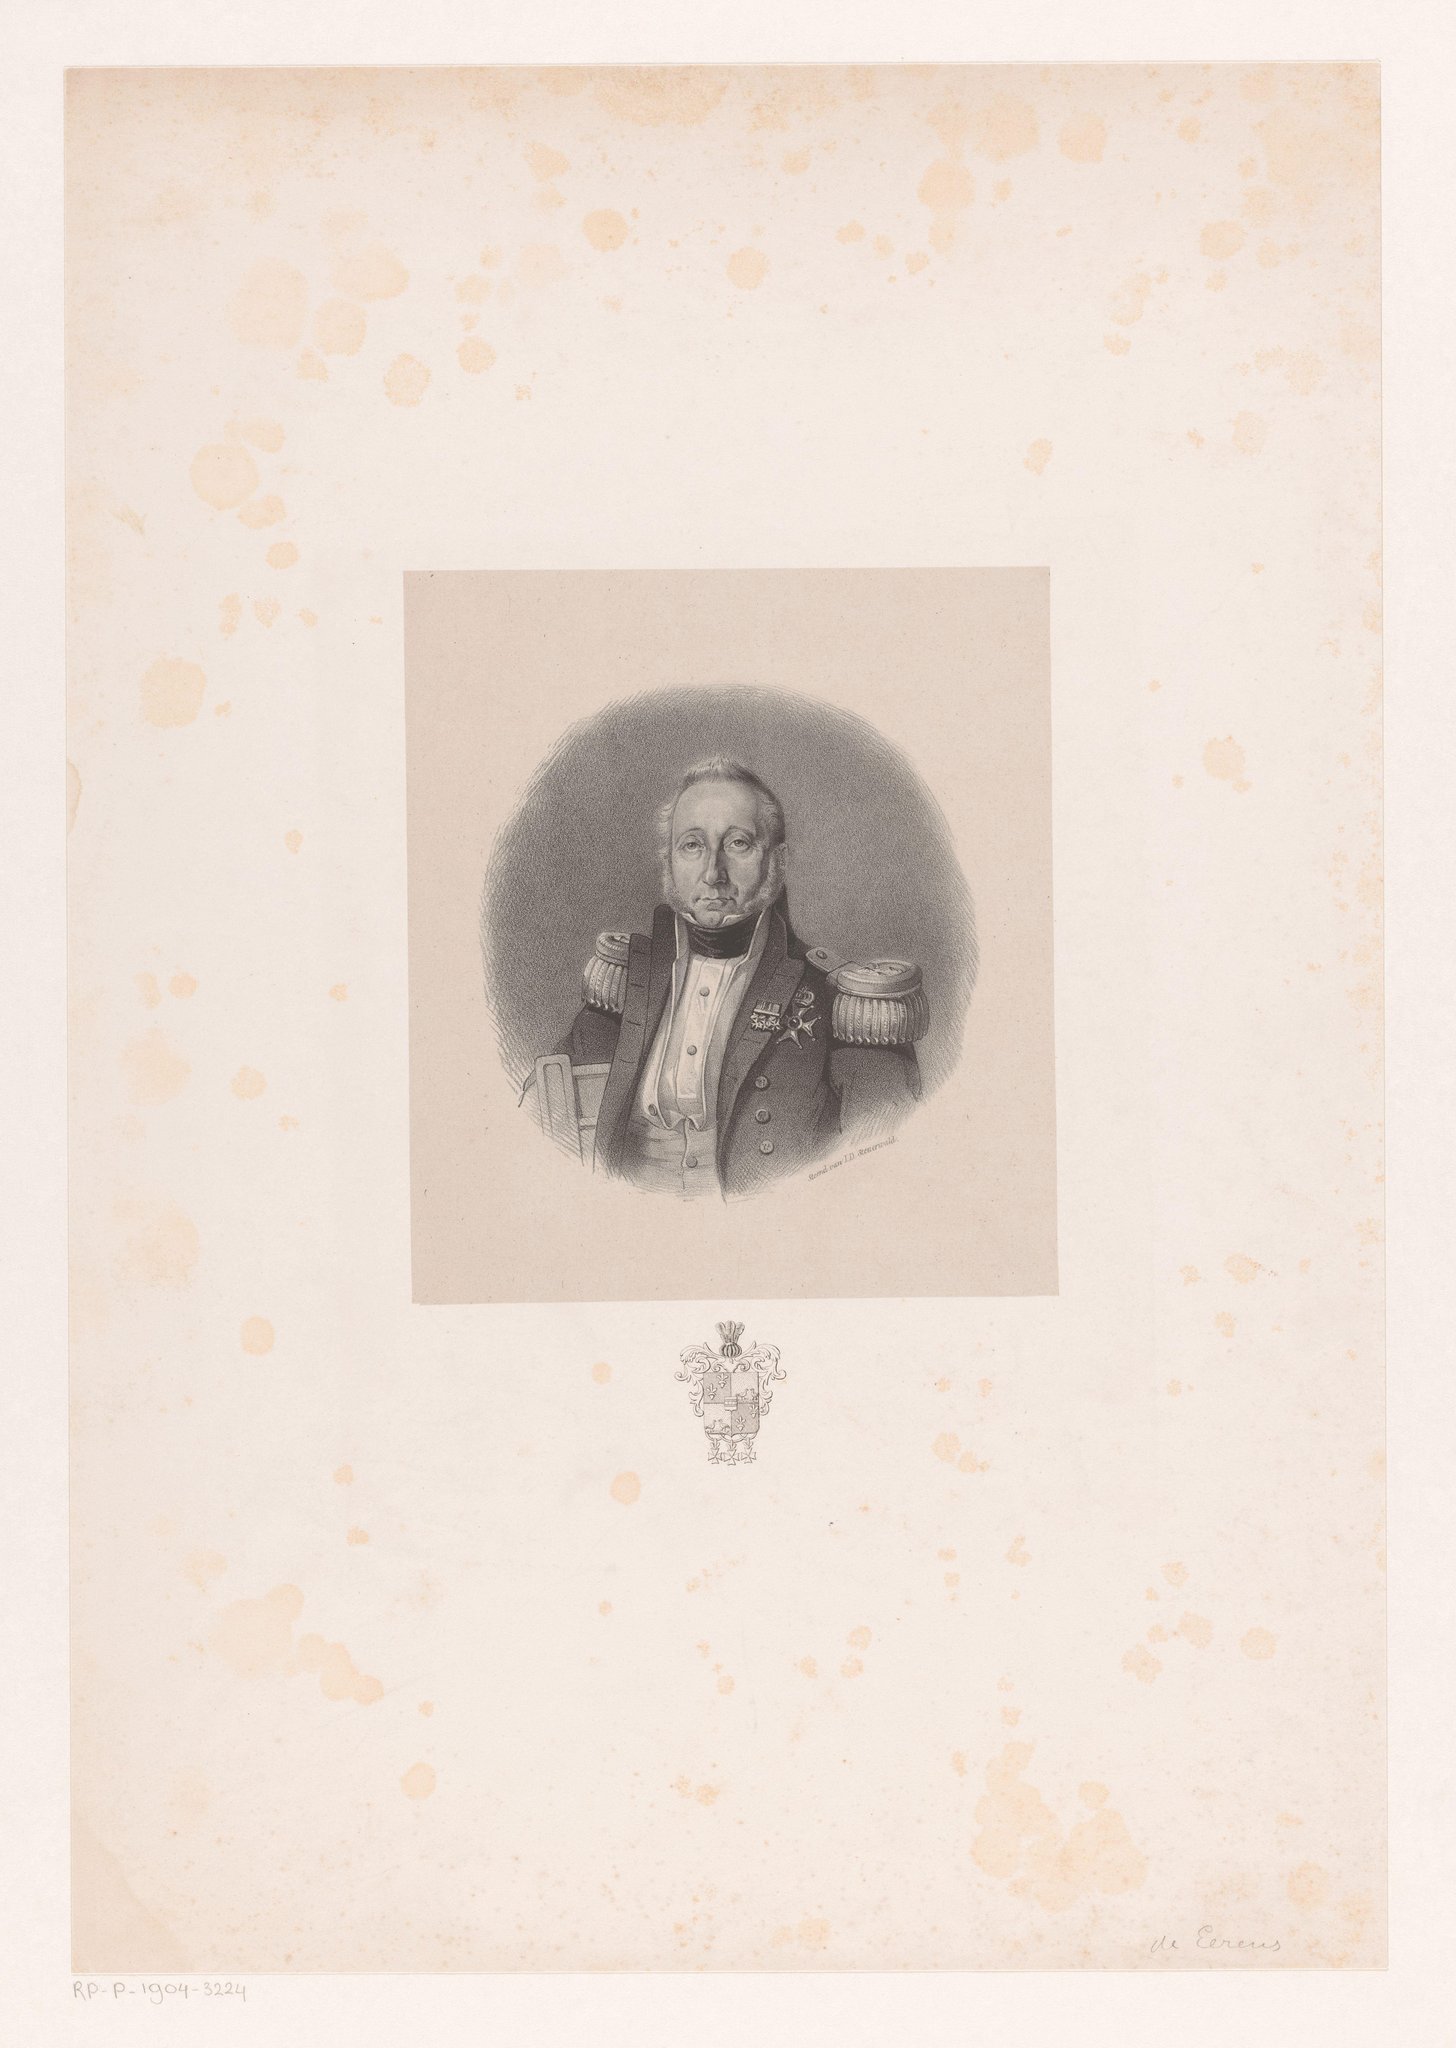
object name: print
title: Portret van Dominique Jacques de Eerens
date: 1822-1863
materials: paper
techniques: lithograph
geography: netherlands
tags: historical persons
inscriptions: collector's mark: Lugt 2228